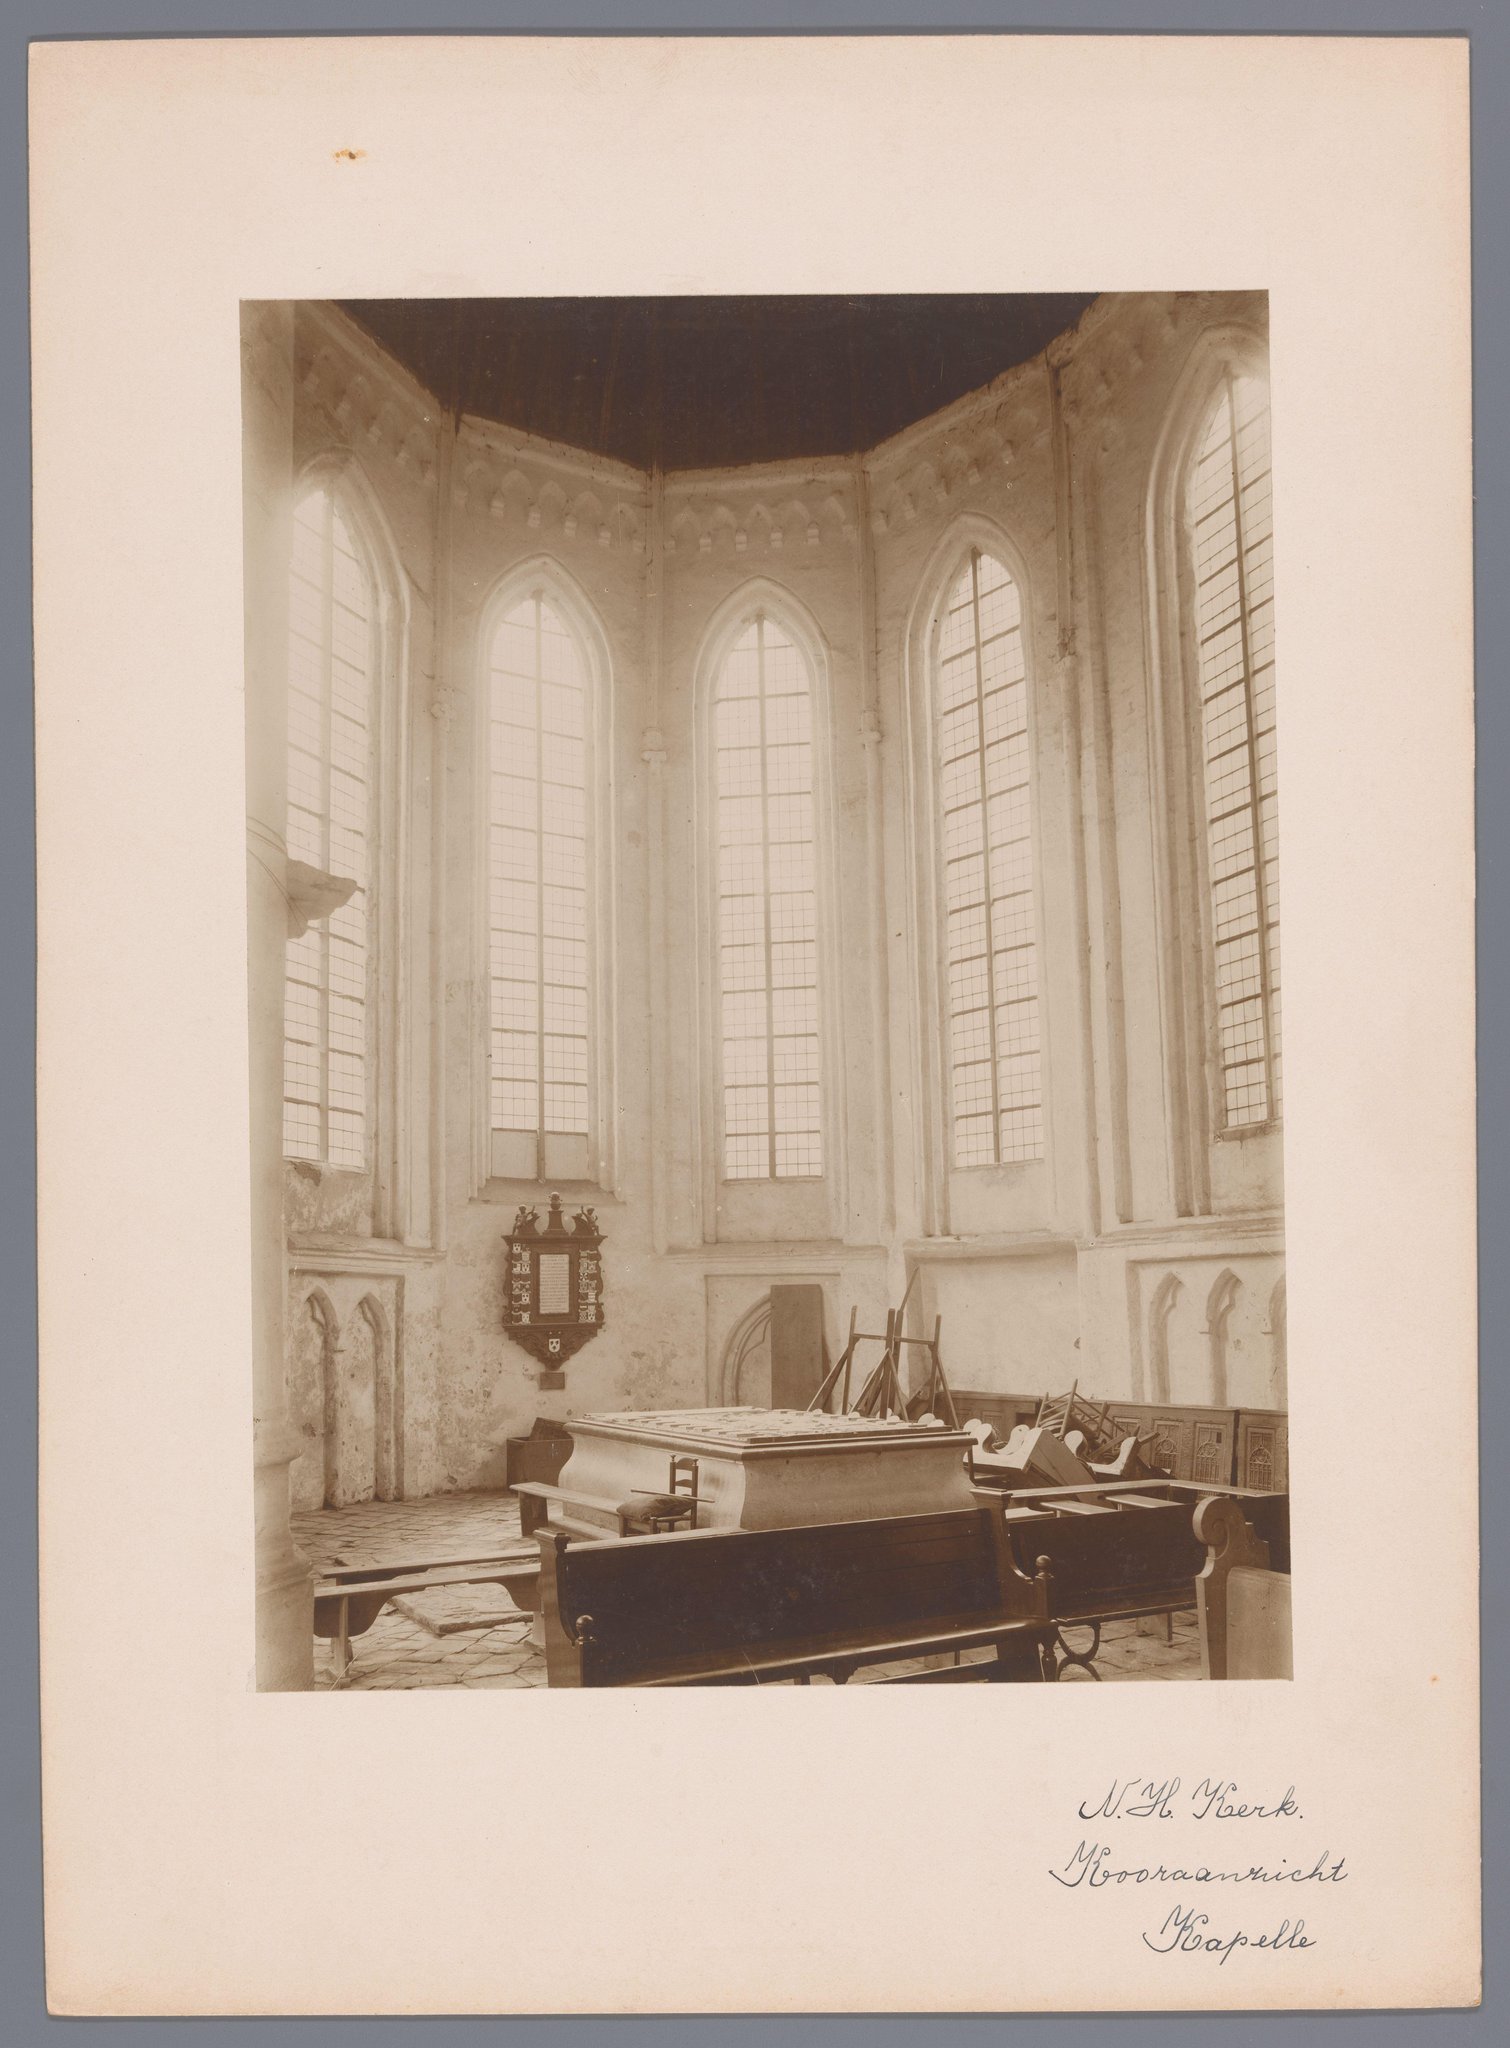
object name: photograph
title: Koor van de Hervormde Kerk te Kapelle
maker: anoniem (monumentenzorg)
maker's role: fotograaf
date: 1896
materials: cardboard, photographic support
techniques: collodion silver print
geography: kapelle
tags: parts of church interior: choir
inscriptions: annotation: ‘N.H. Kerk/ Kooraanzicht/ Kapelle’, annotation: ‘Kapelle Z.B. (Zeeland)/ Aanzicht in het koor der kerk van de Ned. Herv. gemeente/ Oct. 1896’